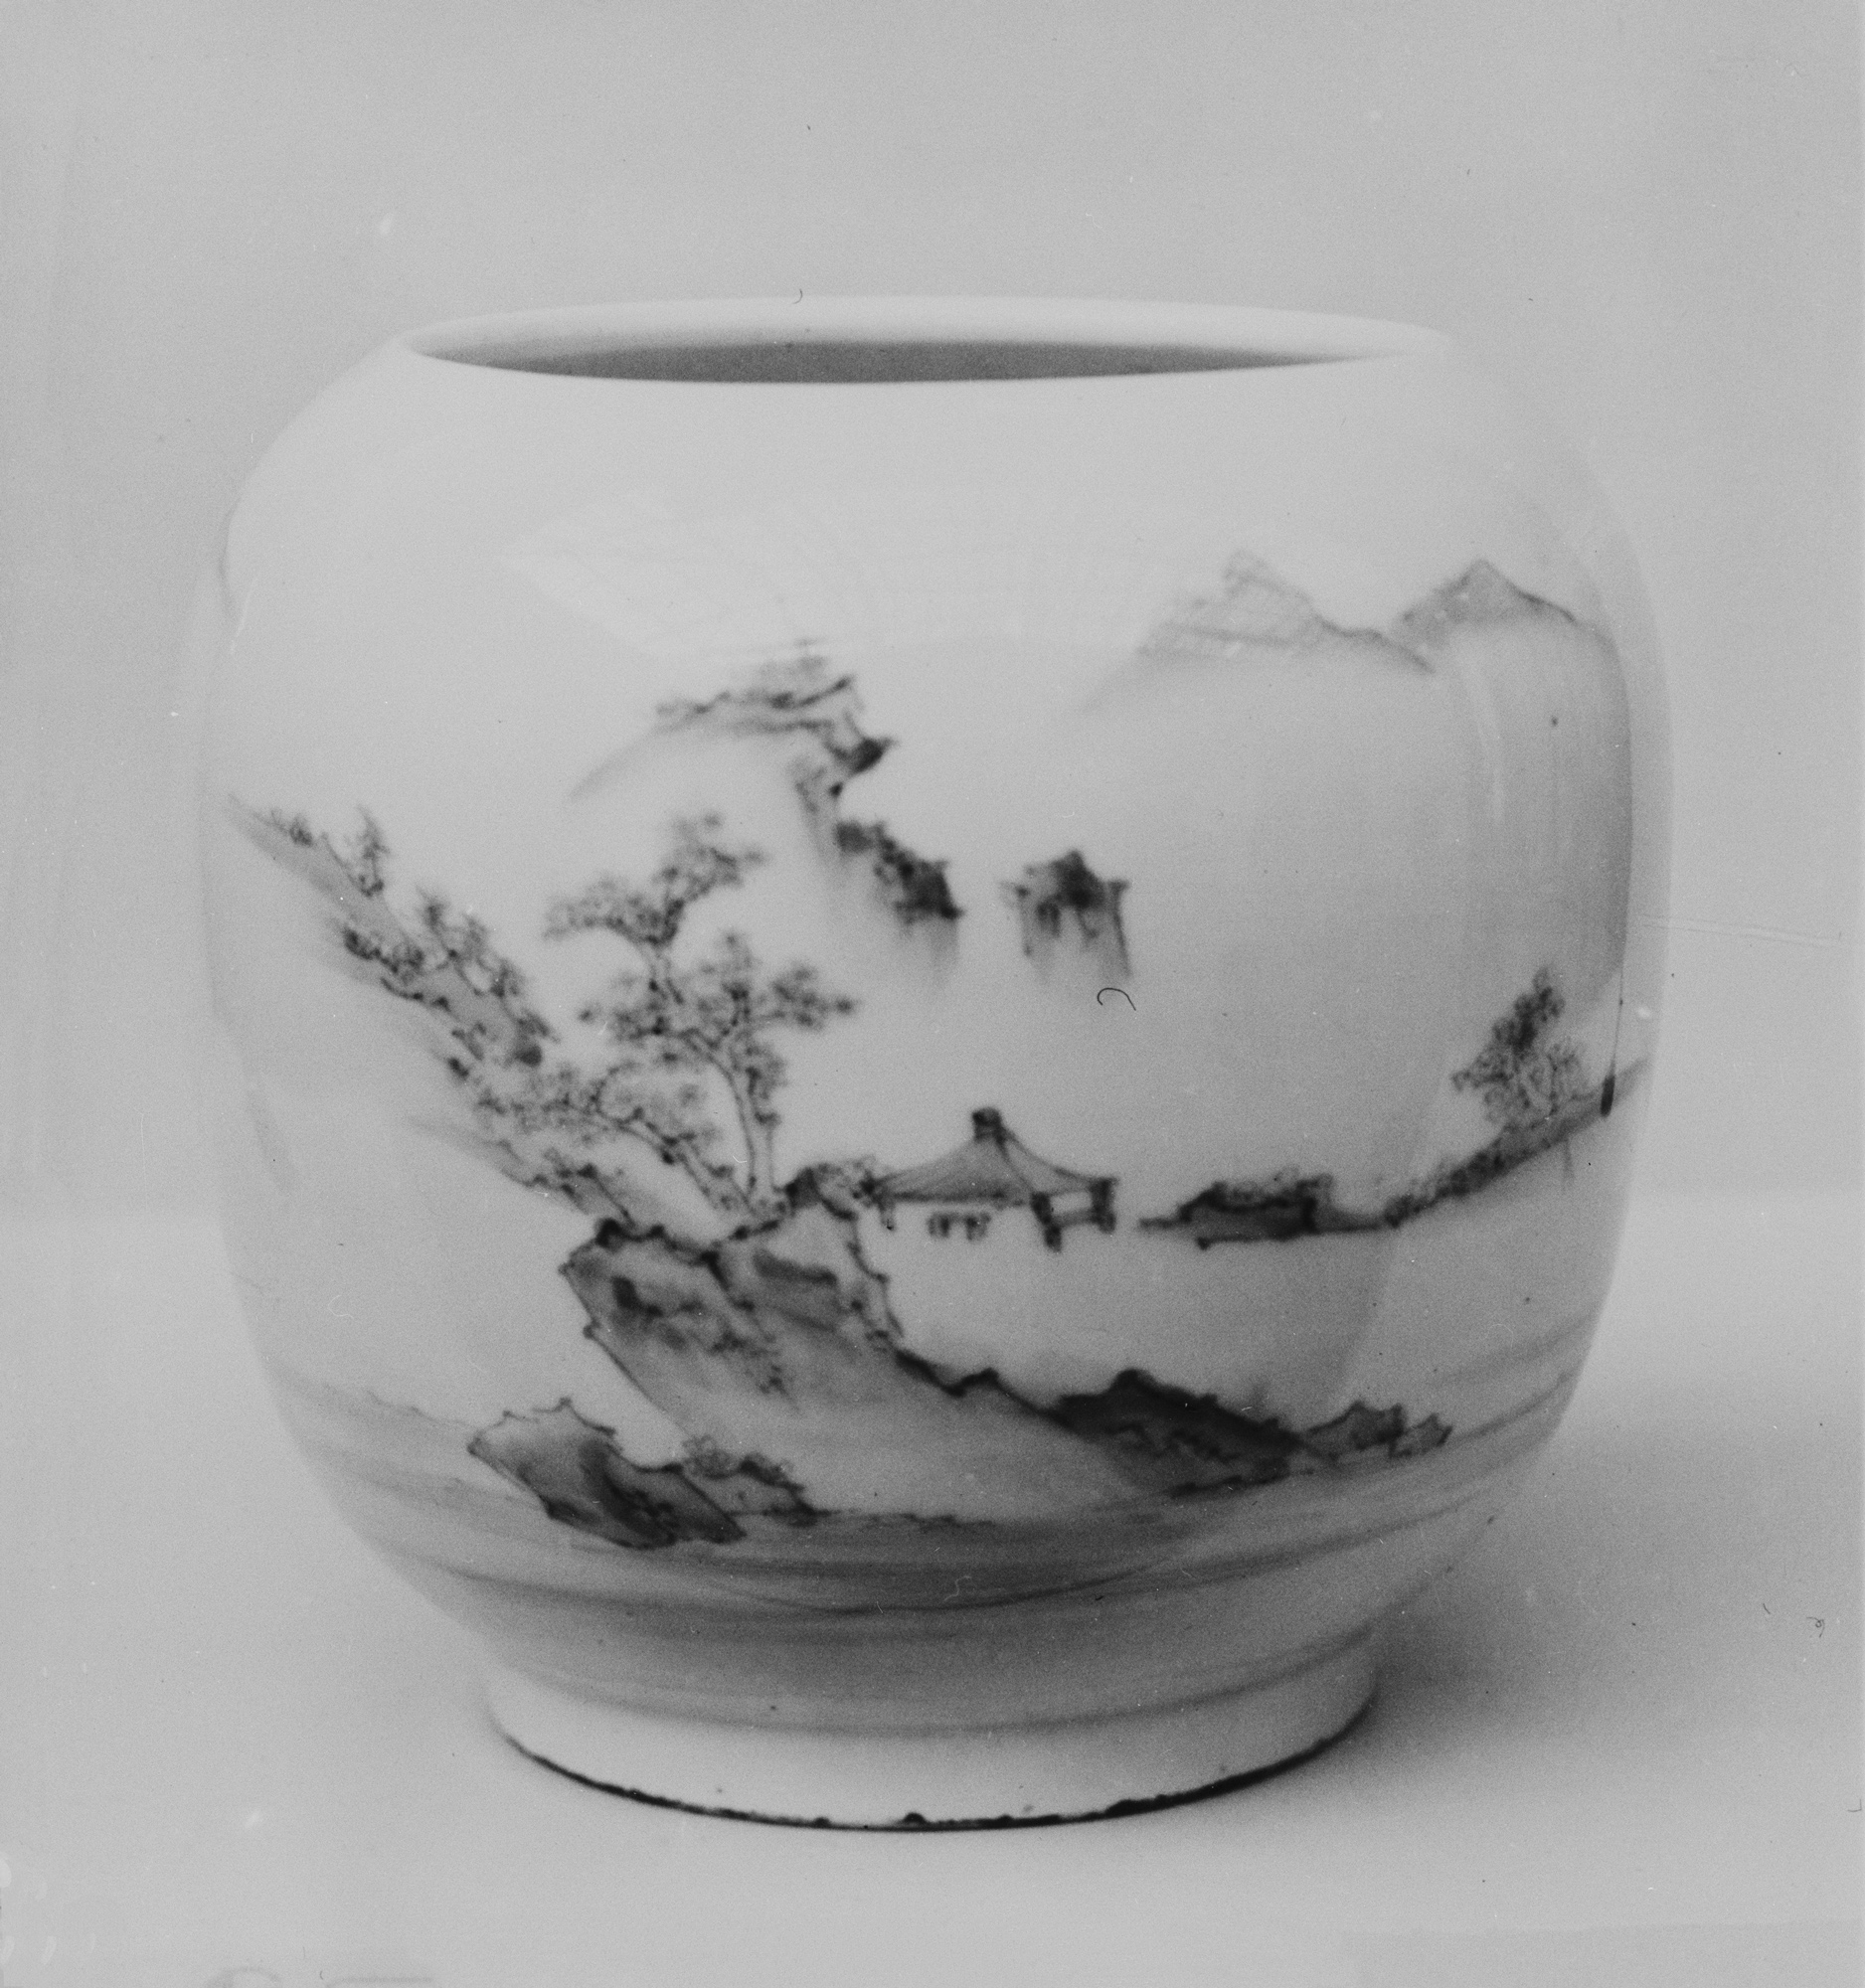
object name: jar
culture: japanese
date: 1820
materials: glaze, porcelain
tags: trees